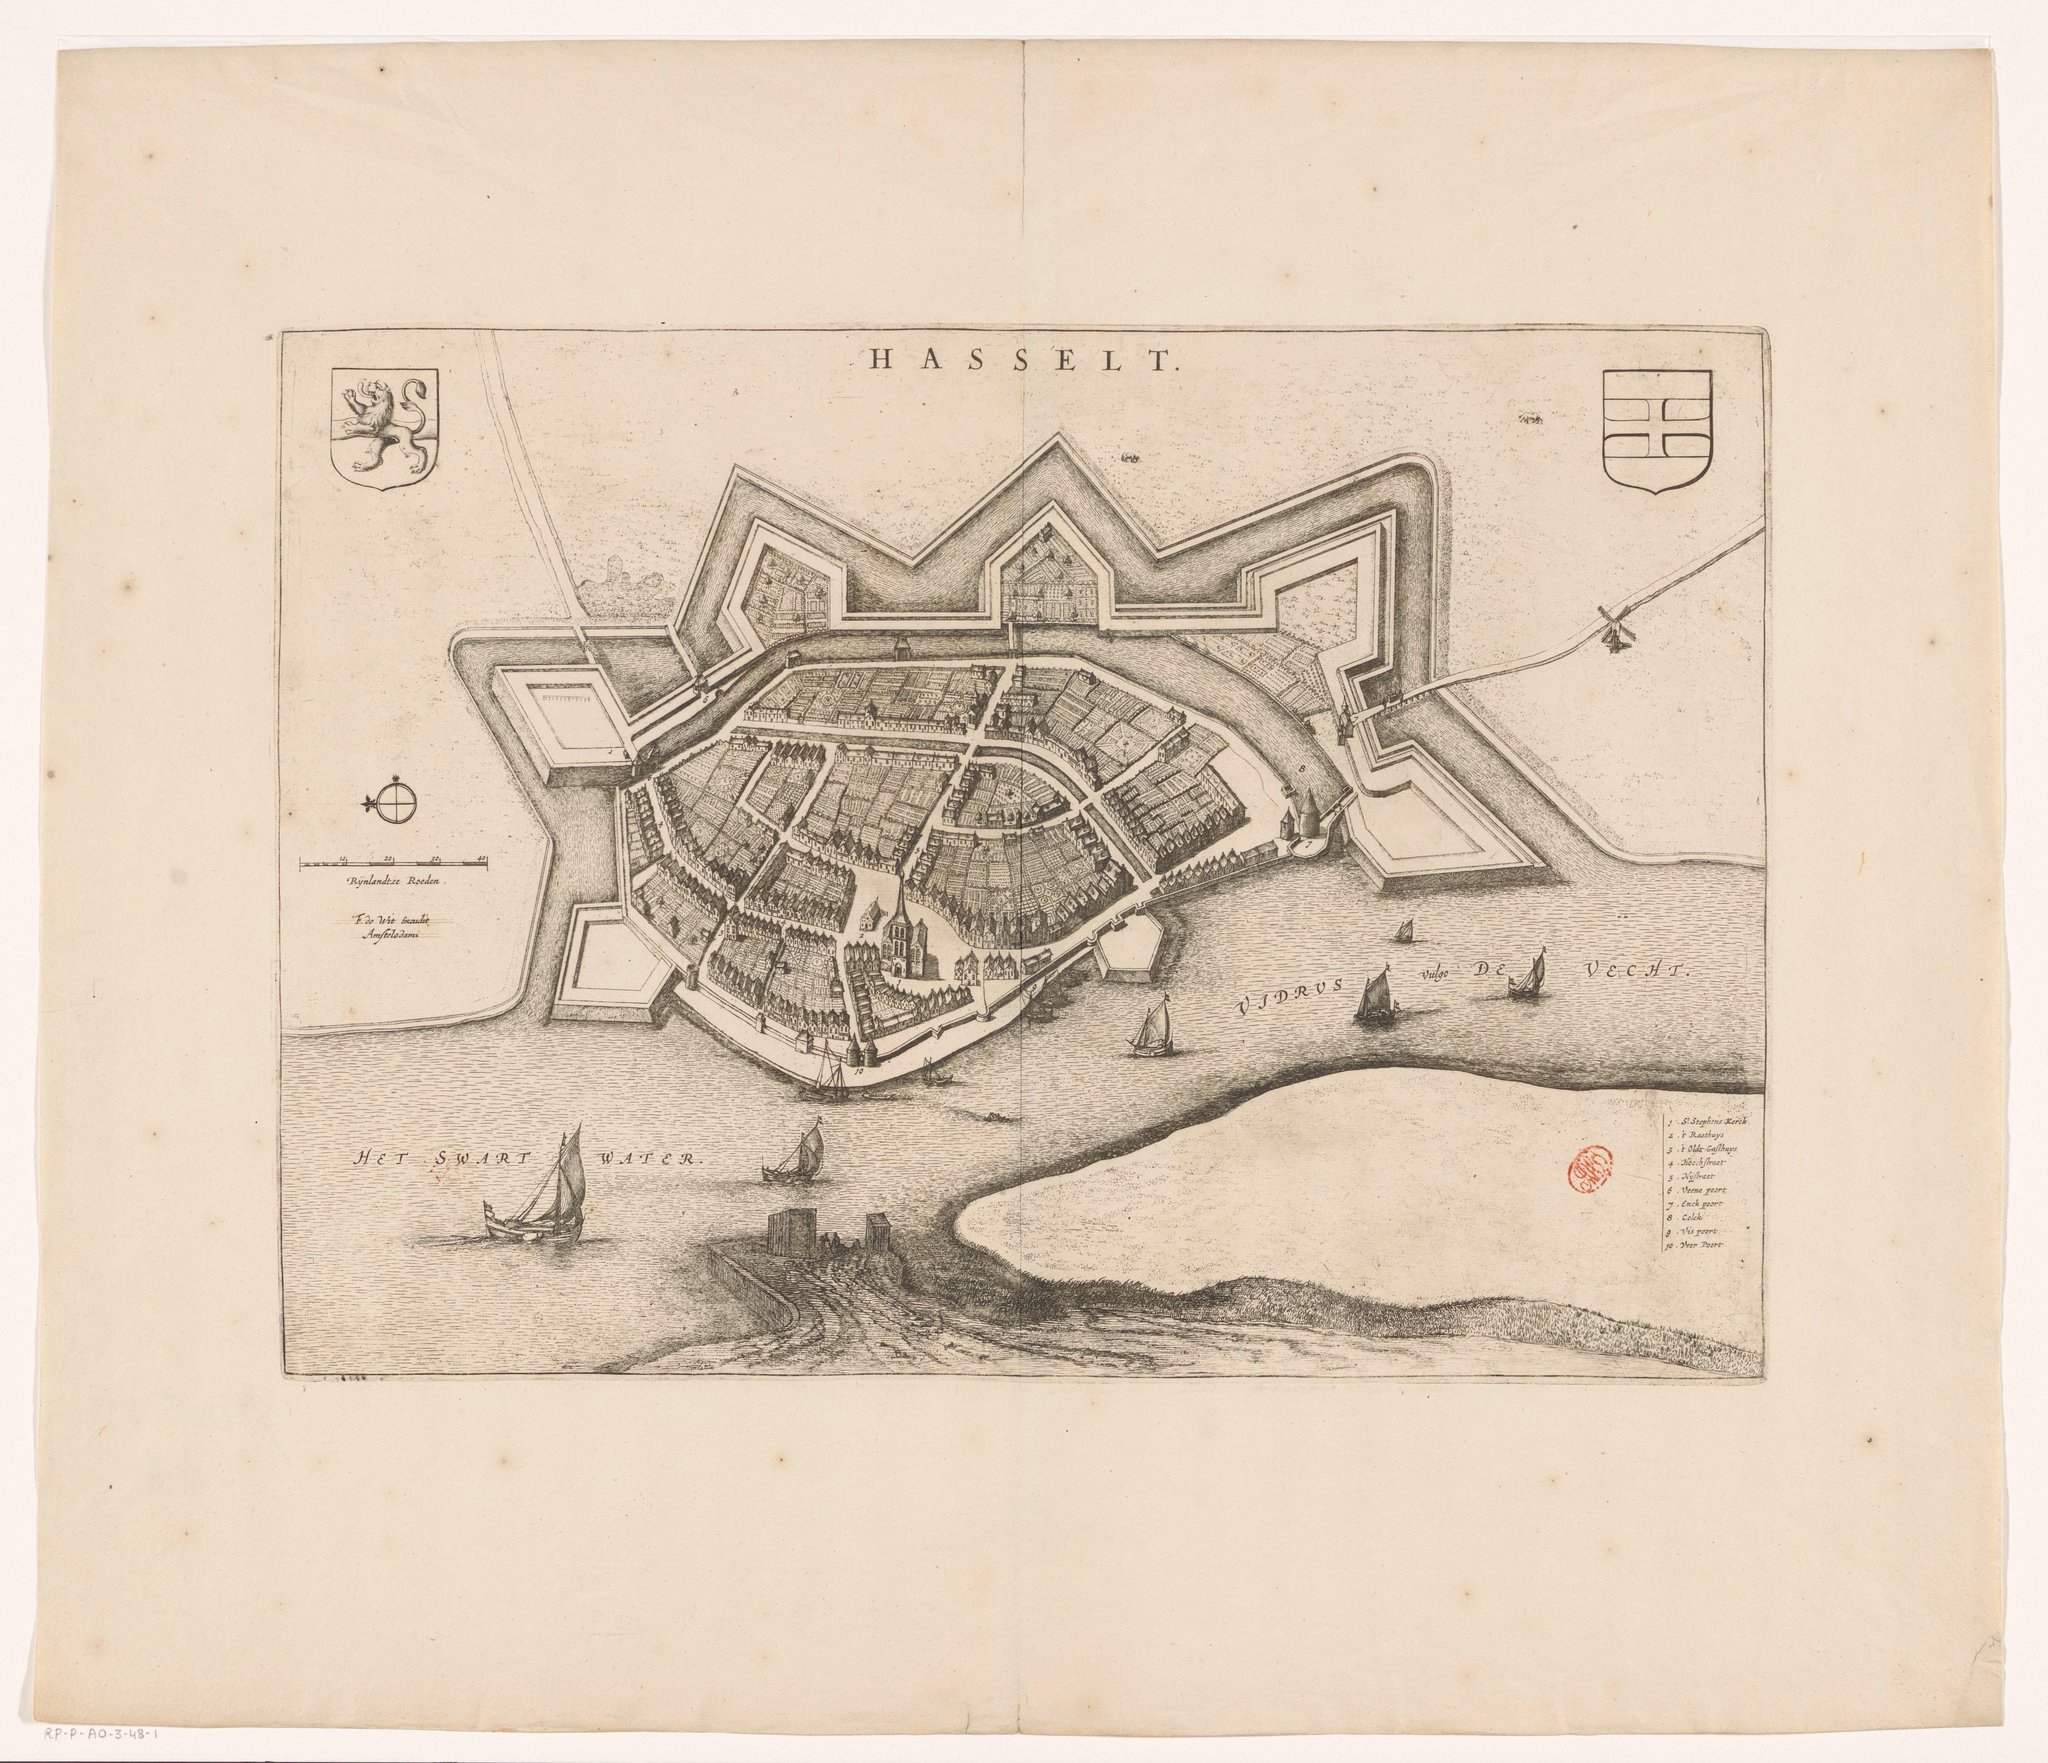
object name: print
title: Plattegrond van Hasselt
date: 1649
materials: paper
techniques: engraving, etching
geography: amsterdam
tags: coat of arms (as symbol of the state, etc.), maps of cities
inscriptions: collector's mark: Lugt 195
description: Plattegrond in vogelvluchtperspectief. Linksboven het wapen van Overijssel. Links in het midden een schaalstok: Rijnlandtze roeden. Rechtsboven het wapen van Hasselt, rechtsonder een legenda.